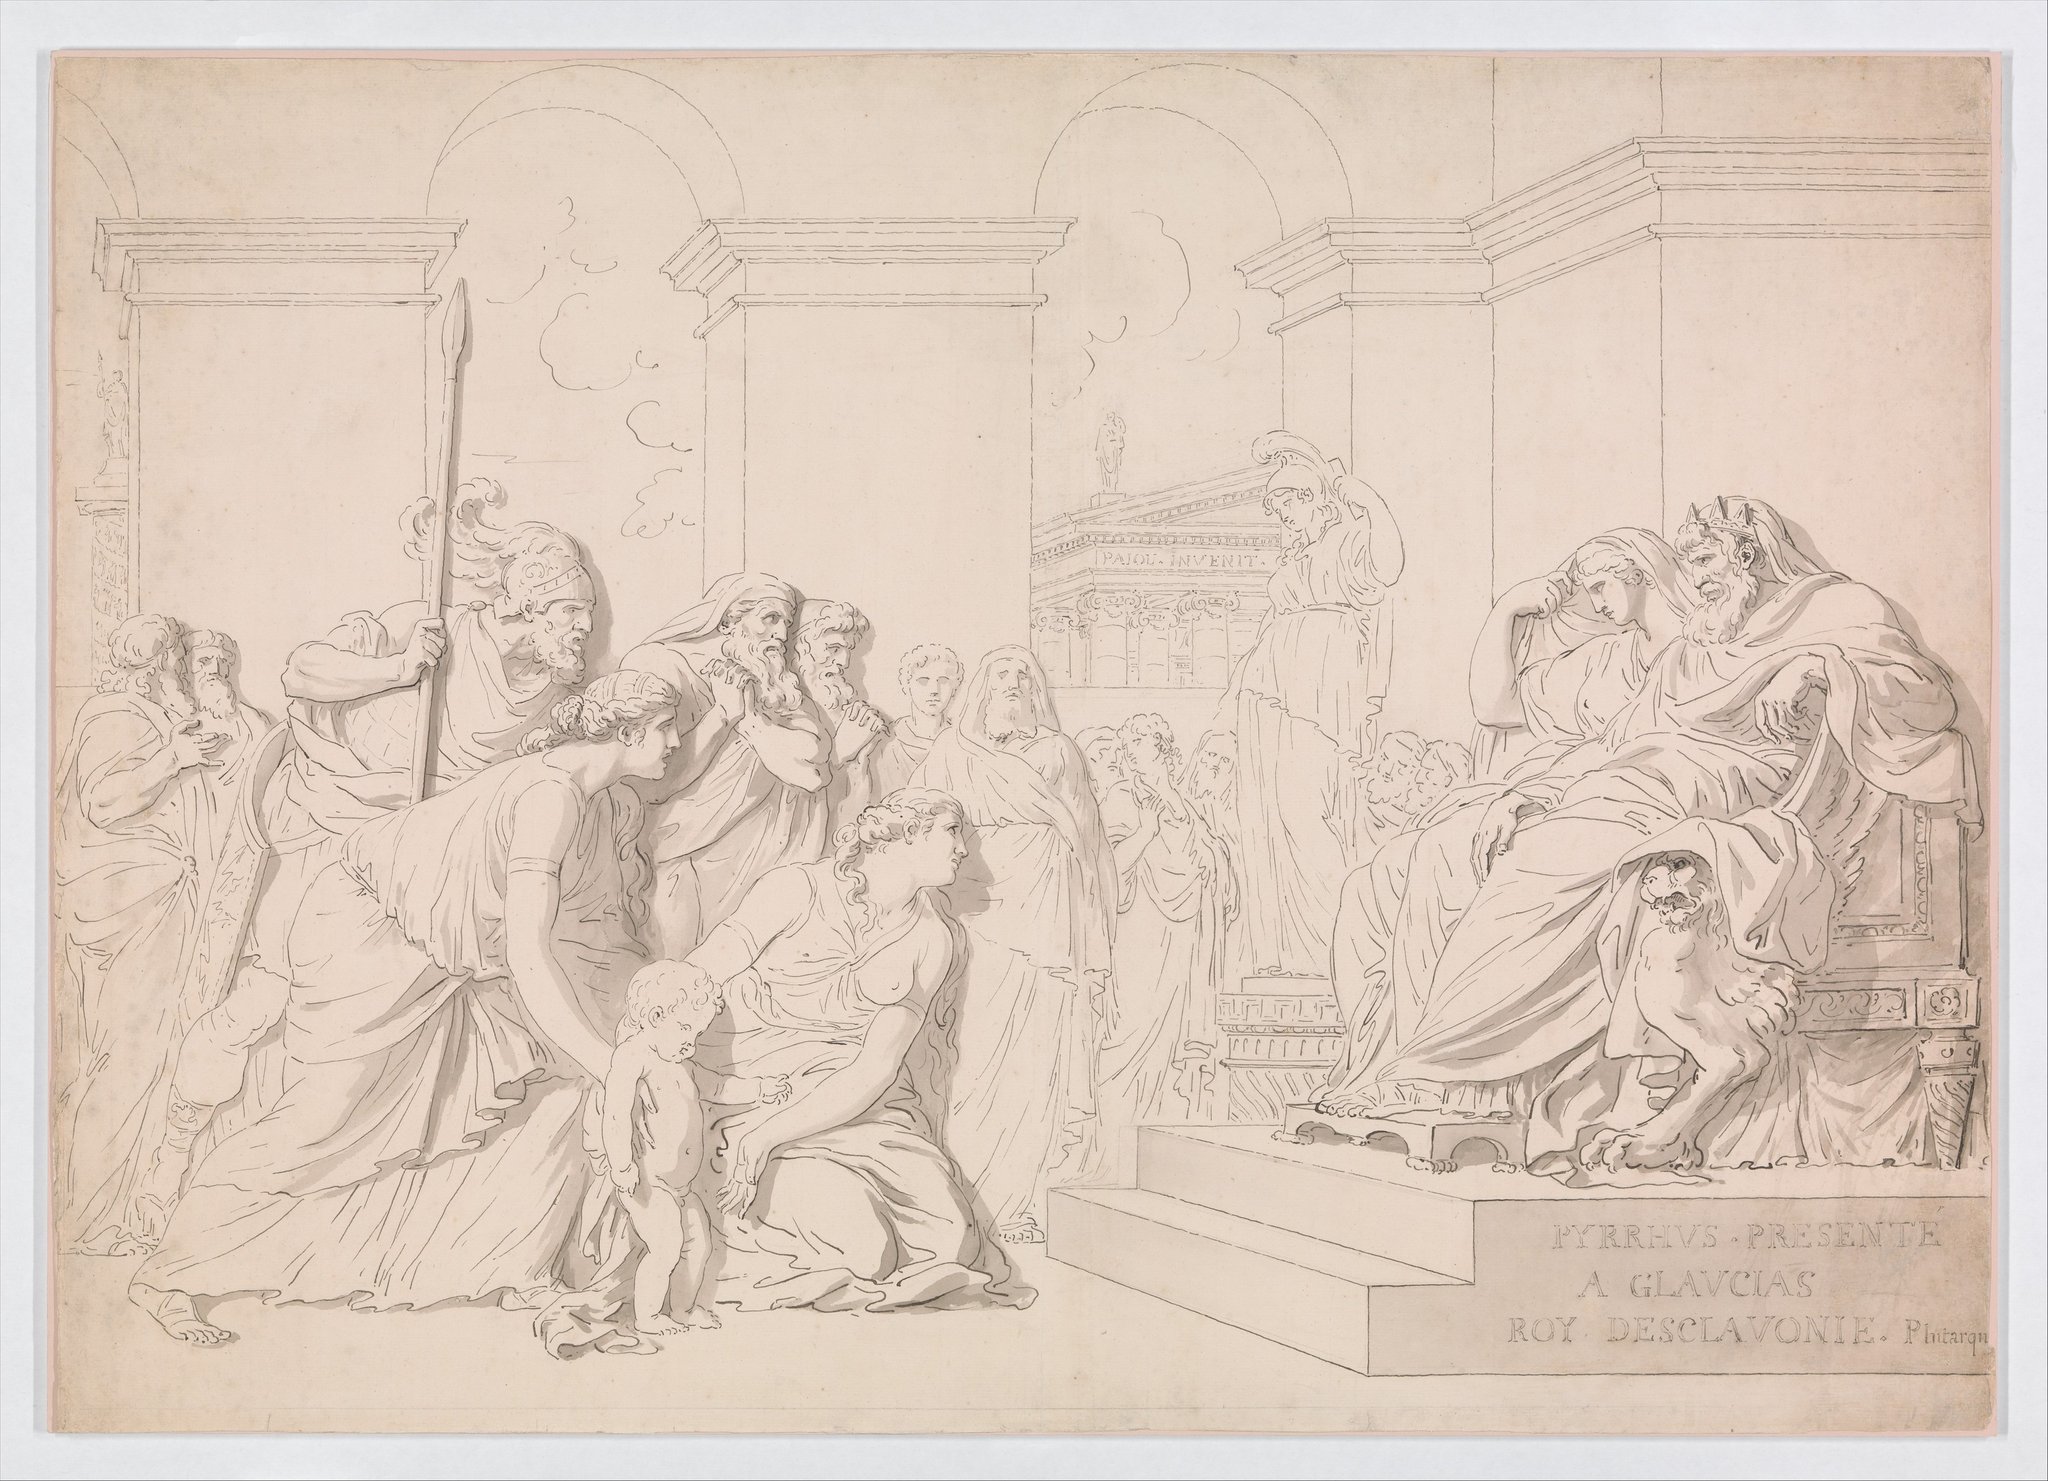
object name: drawing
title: Pyrrhus in the House of Glaucias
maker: augustin pajou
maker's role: artist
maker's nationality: french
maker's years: 1730-1809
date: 1752-1756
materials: chalk, ink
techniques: brush, pen, wash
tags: kings,infants,men,women